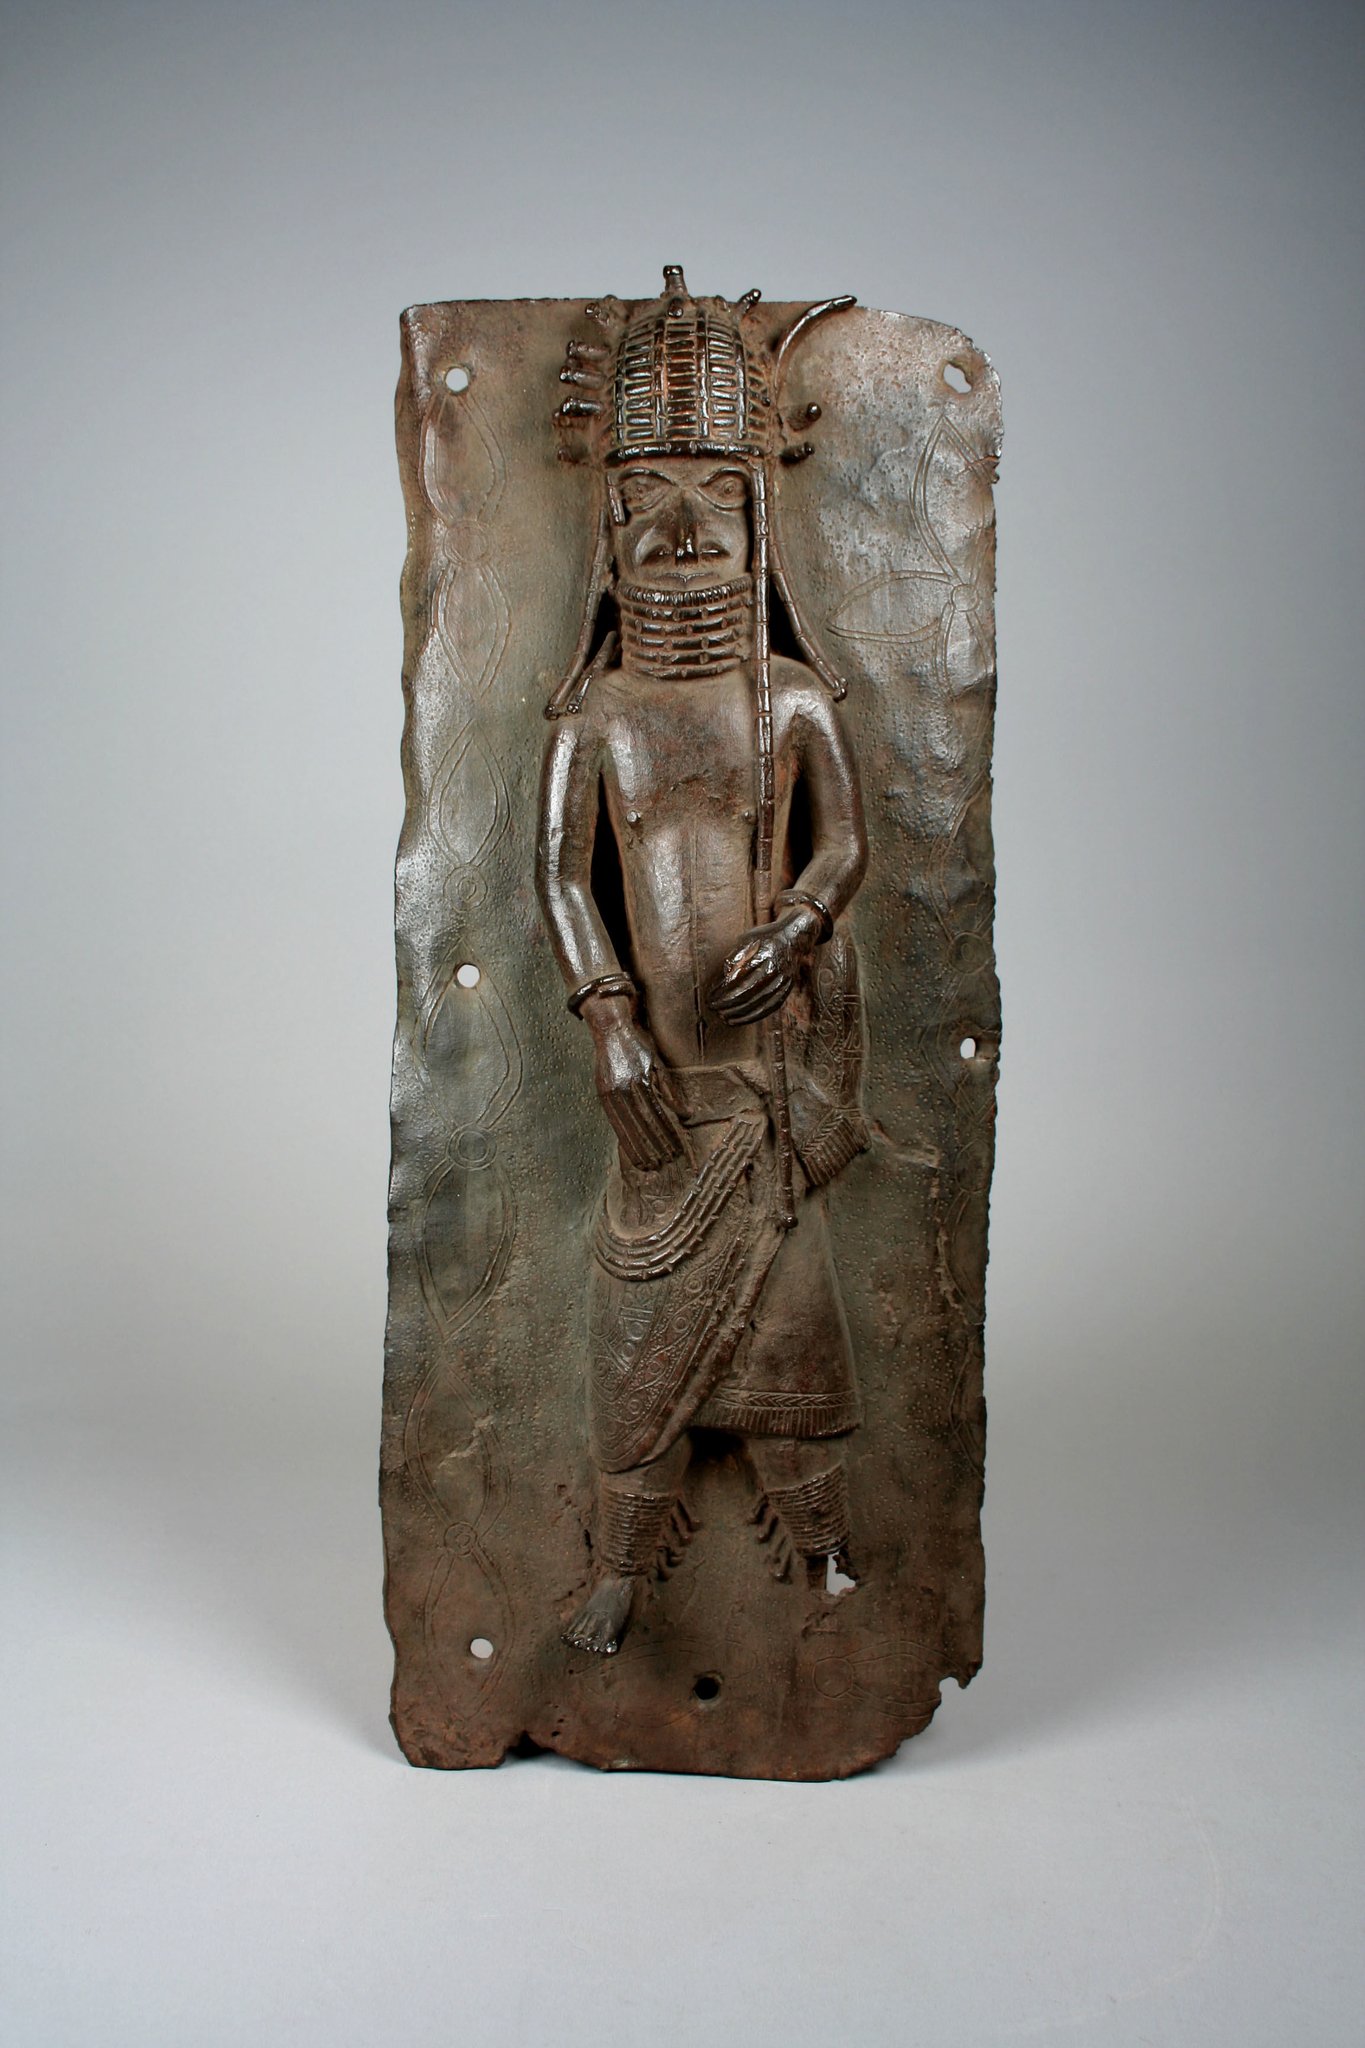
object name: plaque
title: Plaque: Warrior Chief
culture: edo period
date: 1550-1680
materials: brass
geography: nigeria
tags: men